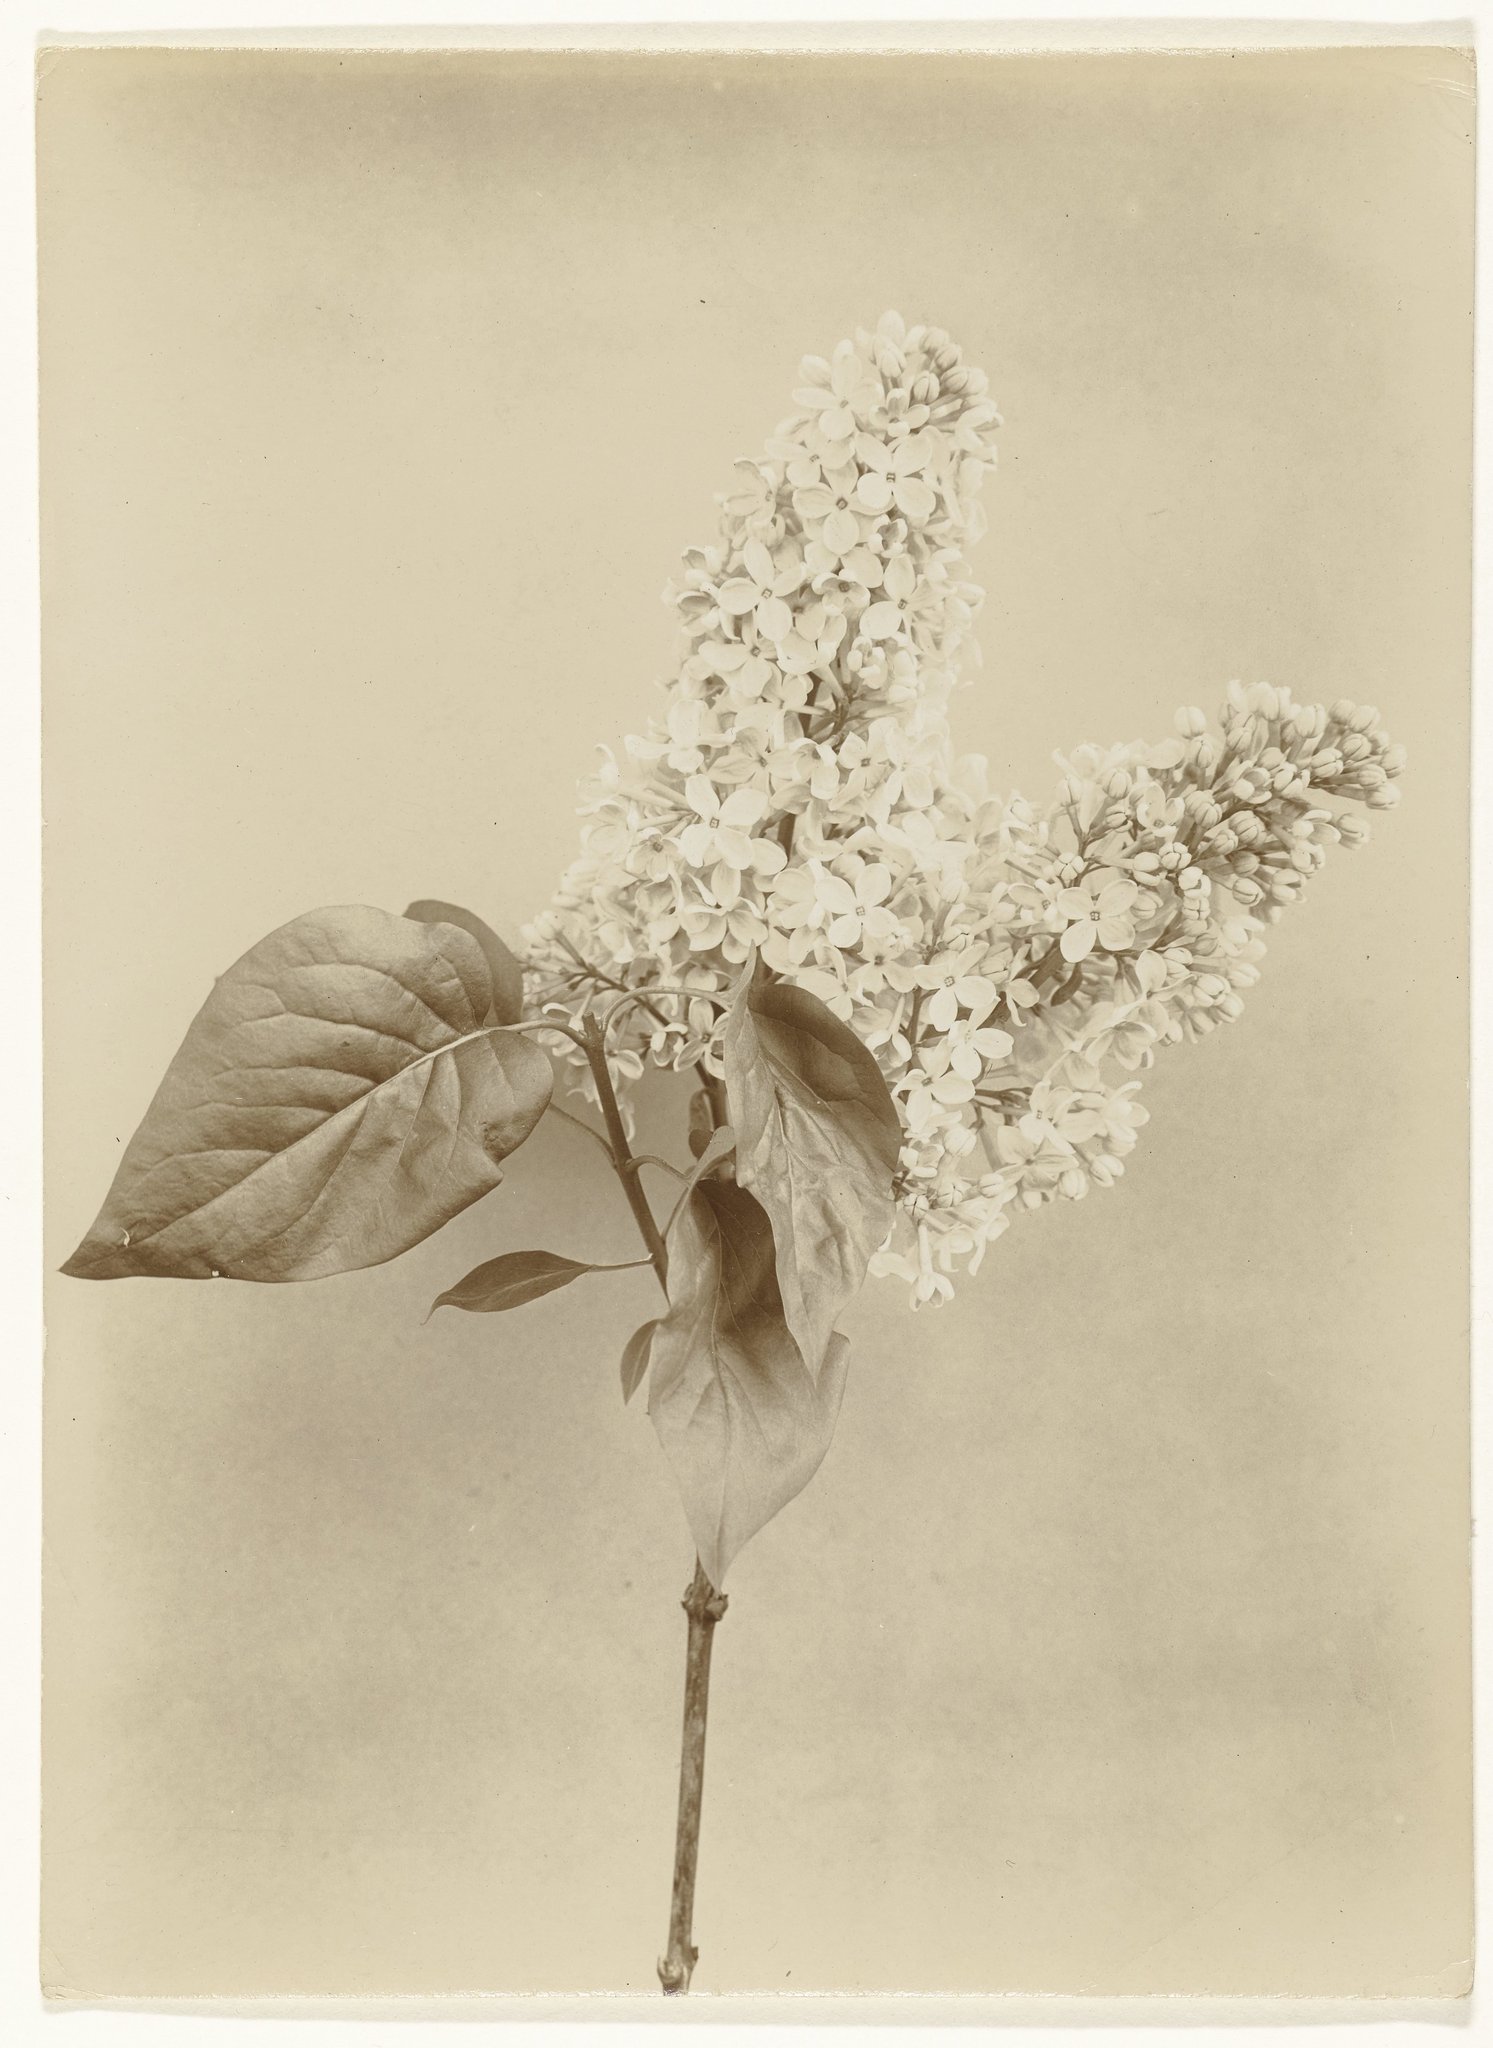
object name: photograph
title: Bloeiende Seringentak Charles X ver[(...)]igd uit Aalsmeer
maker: richard tepe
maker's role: fotograaf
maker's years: 1864-1952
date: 1900-1930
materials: photographic support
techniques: gelatin silver print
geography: netherlands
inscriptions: annotation: ‘Bloeiende / Seringentak / Charles X / ver[...]igd / uit Aalsmeer’, signature: ‘foto / R Tepe’